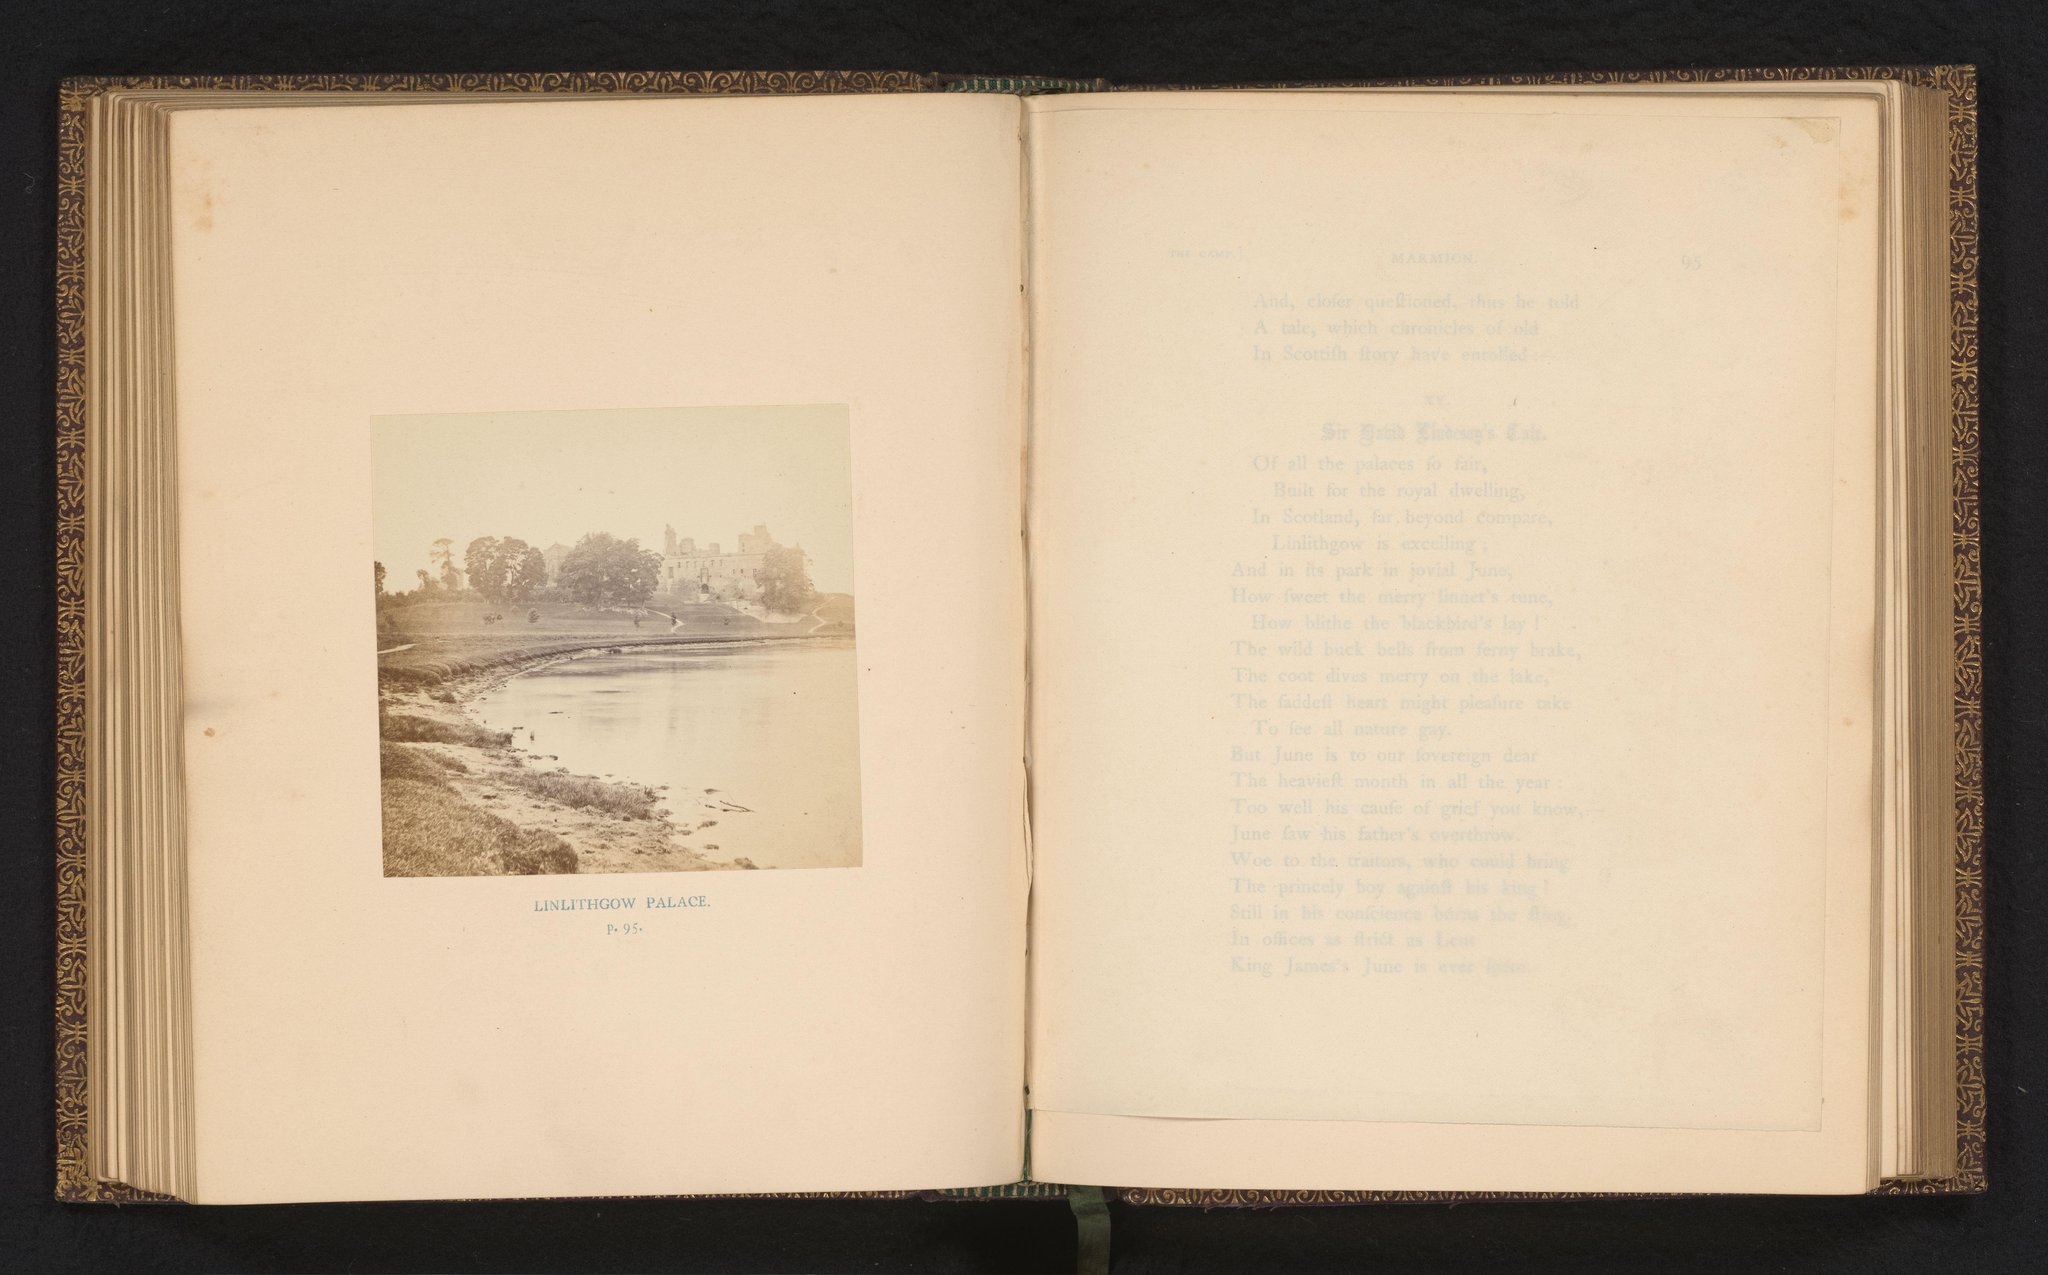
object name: page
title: Linlithgow Palace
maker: thomas annan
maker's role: fotograaf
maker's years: 1829-1887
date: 1861-1866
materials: paper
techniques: albumen print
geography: west lothian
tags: castle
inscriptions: inscription: ‘p. 95.’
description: Foto op ongenummerde pagina tegenover pagina 95.